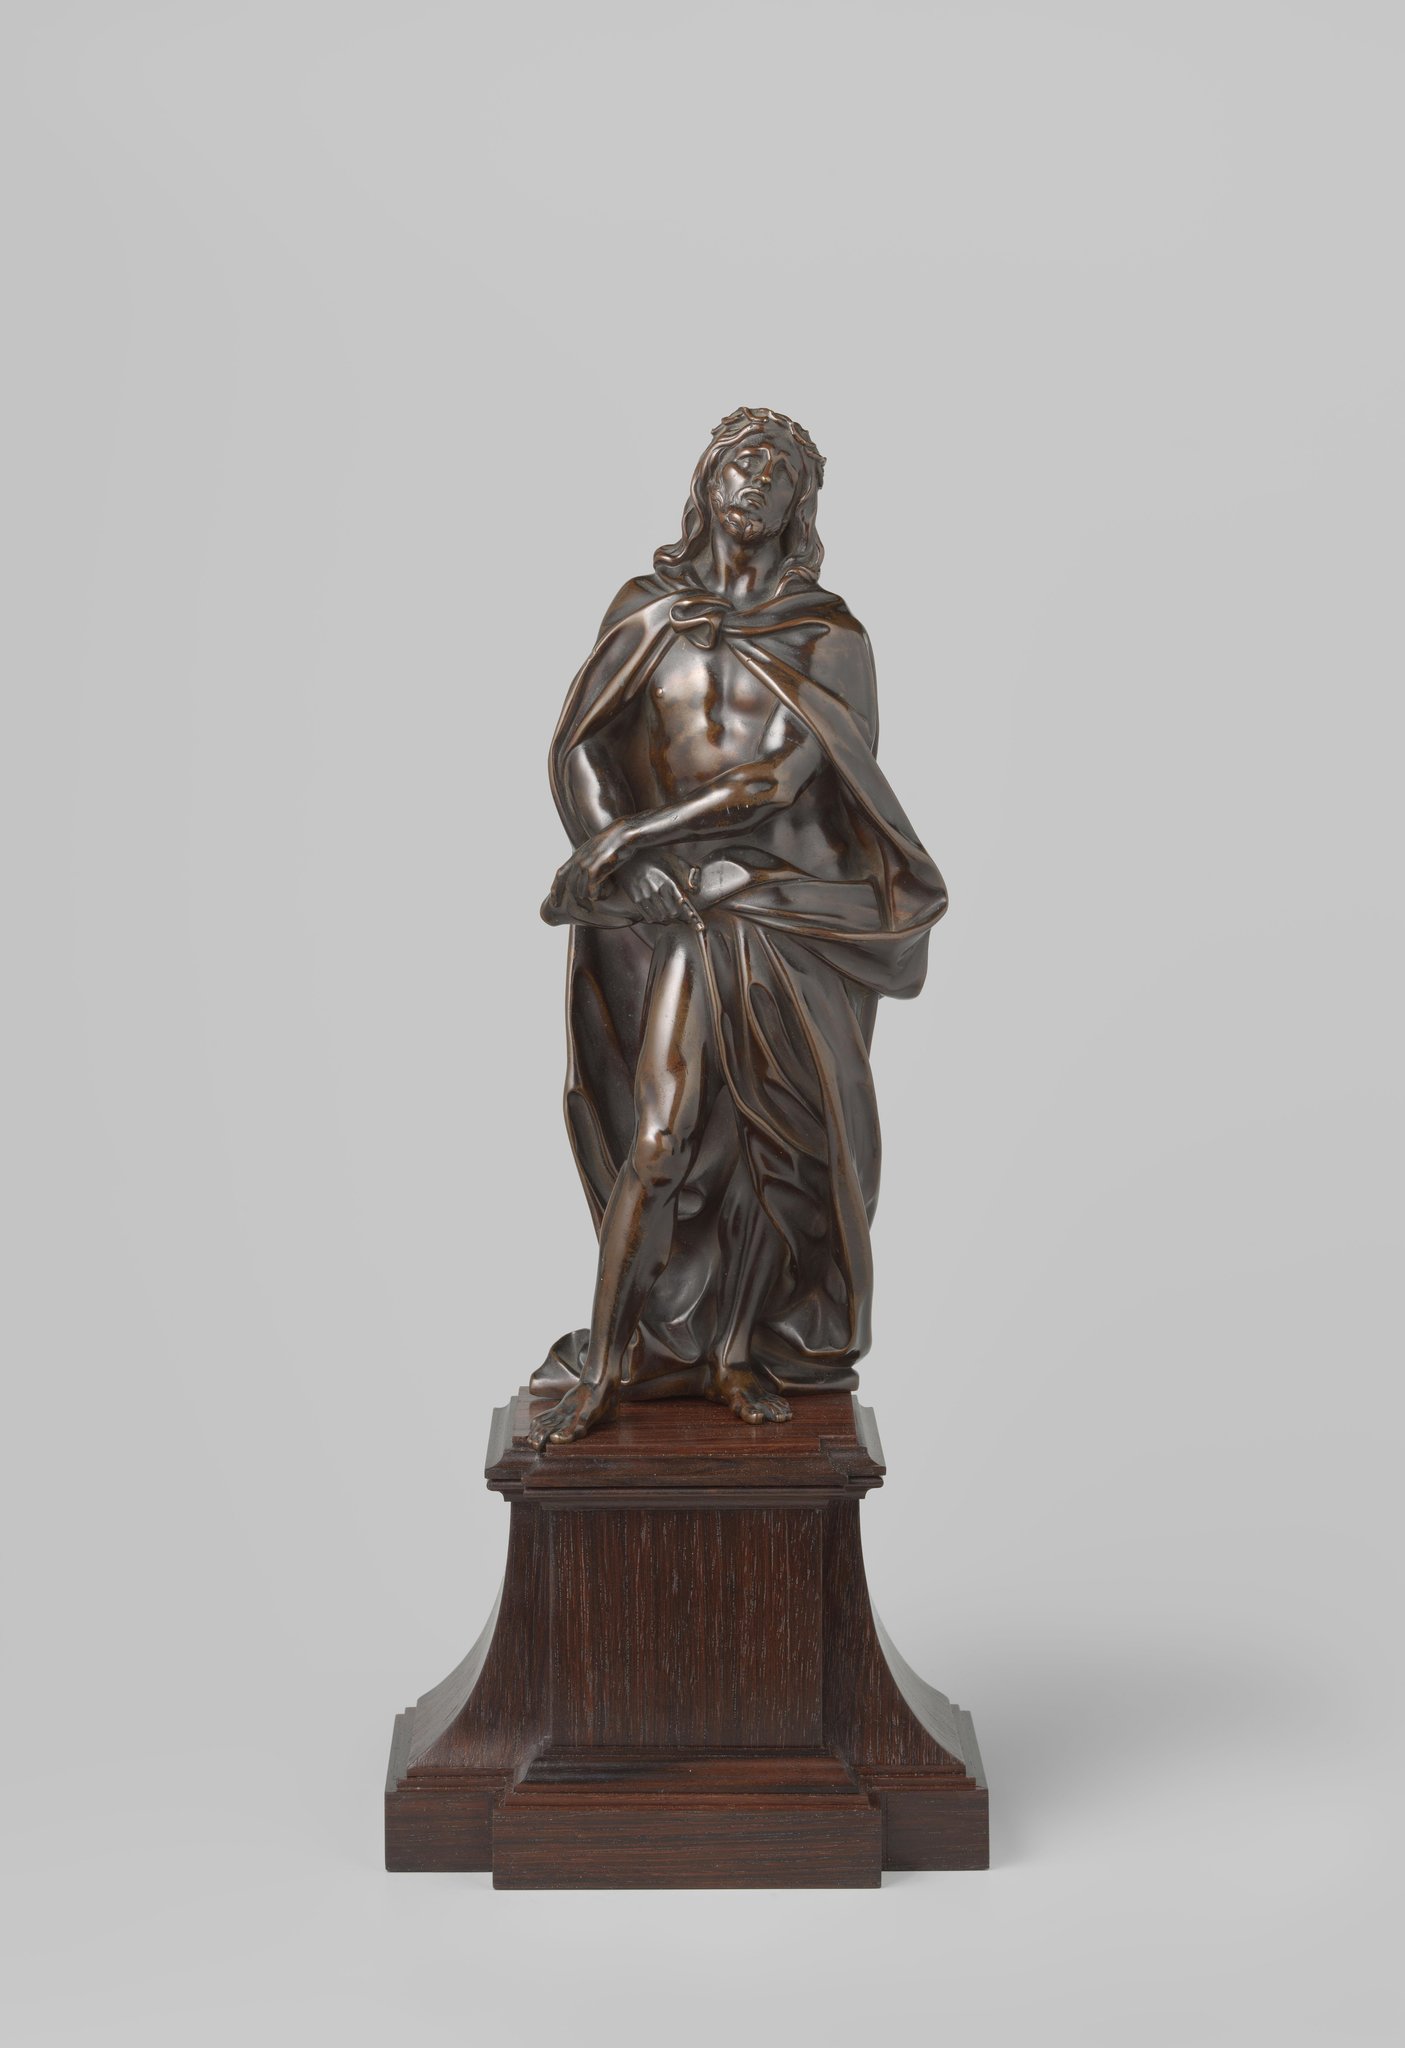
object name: sculpture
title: Ecce Homo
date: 1640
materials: bronze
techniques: casting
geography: rome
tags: christ alone (also called 'ecce homo')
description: These bronzes depict two episodes of the Passion story: the Flagellation and the Mocking of Christ. The French sculptor Girardon likely first cast Christ Bound to the Column (the Flagellation), originally designed by Du Quesnoy, around 1690. Subsequently, he added the Mocking of Christ after his own design. Although the figures are almost mirror images, their heads contrast, one looking downward, the other toward heaven. The two figurines were reunited in 2021.